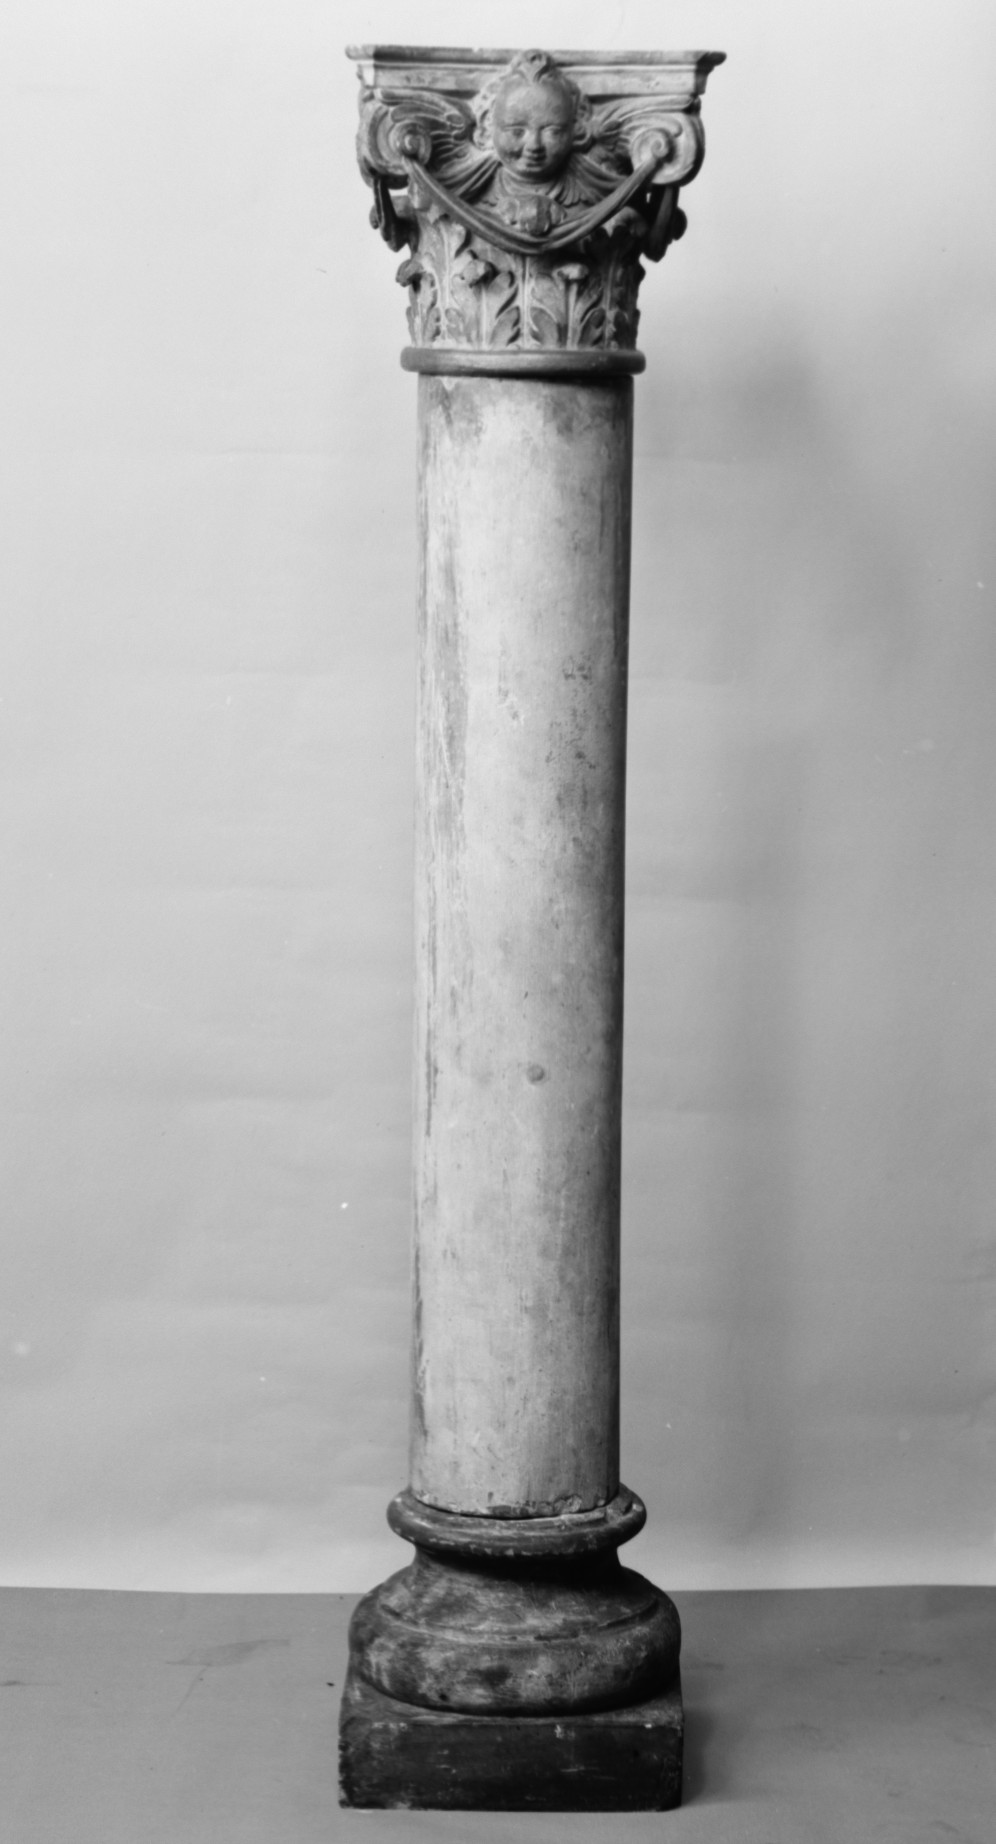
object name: column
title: Column (one of a pair)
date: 1500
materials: limestone